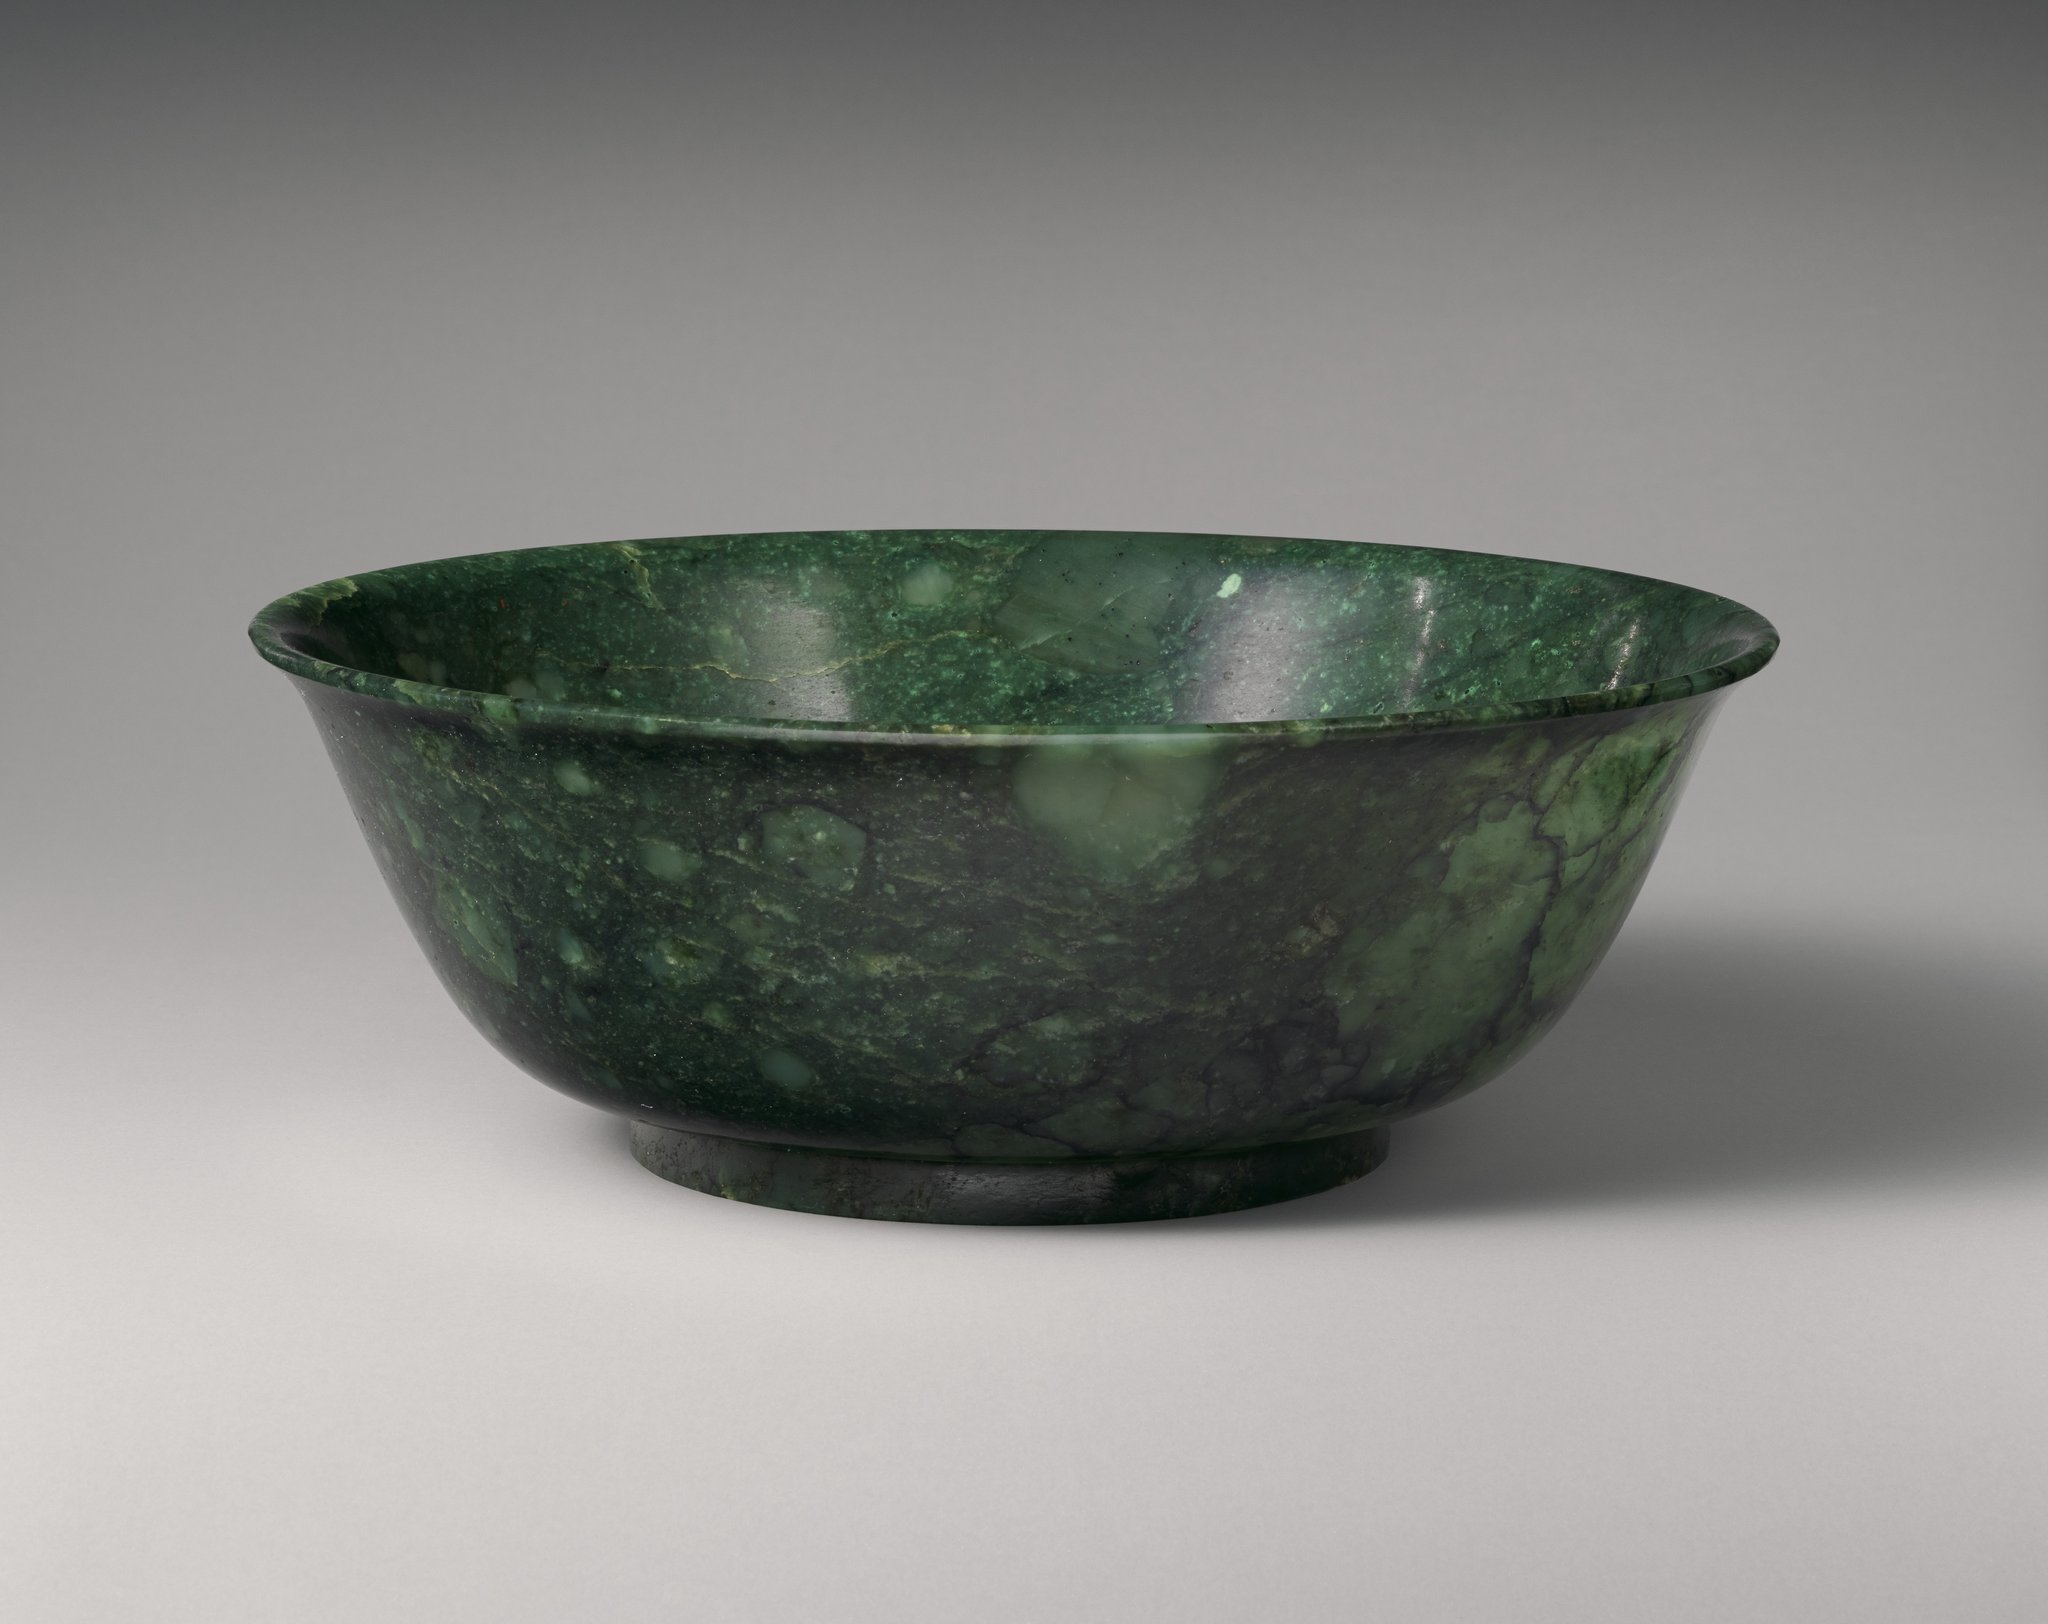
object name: bowl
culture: chinese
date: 1368-1644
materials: jade